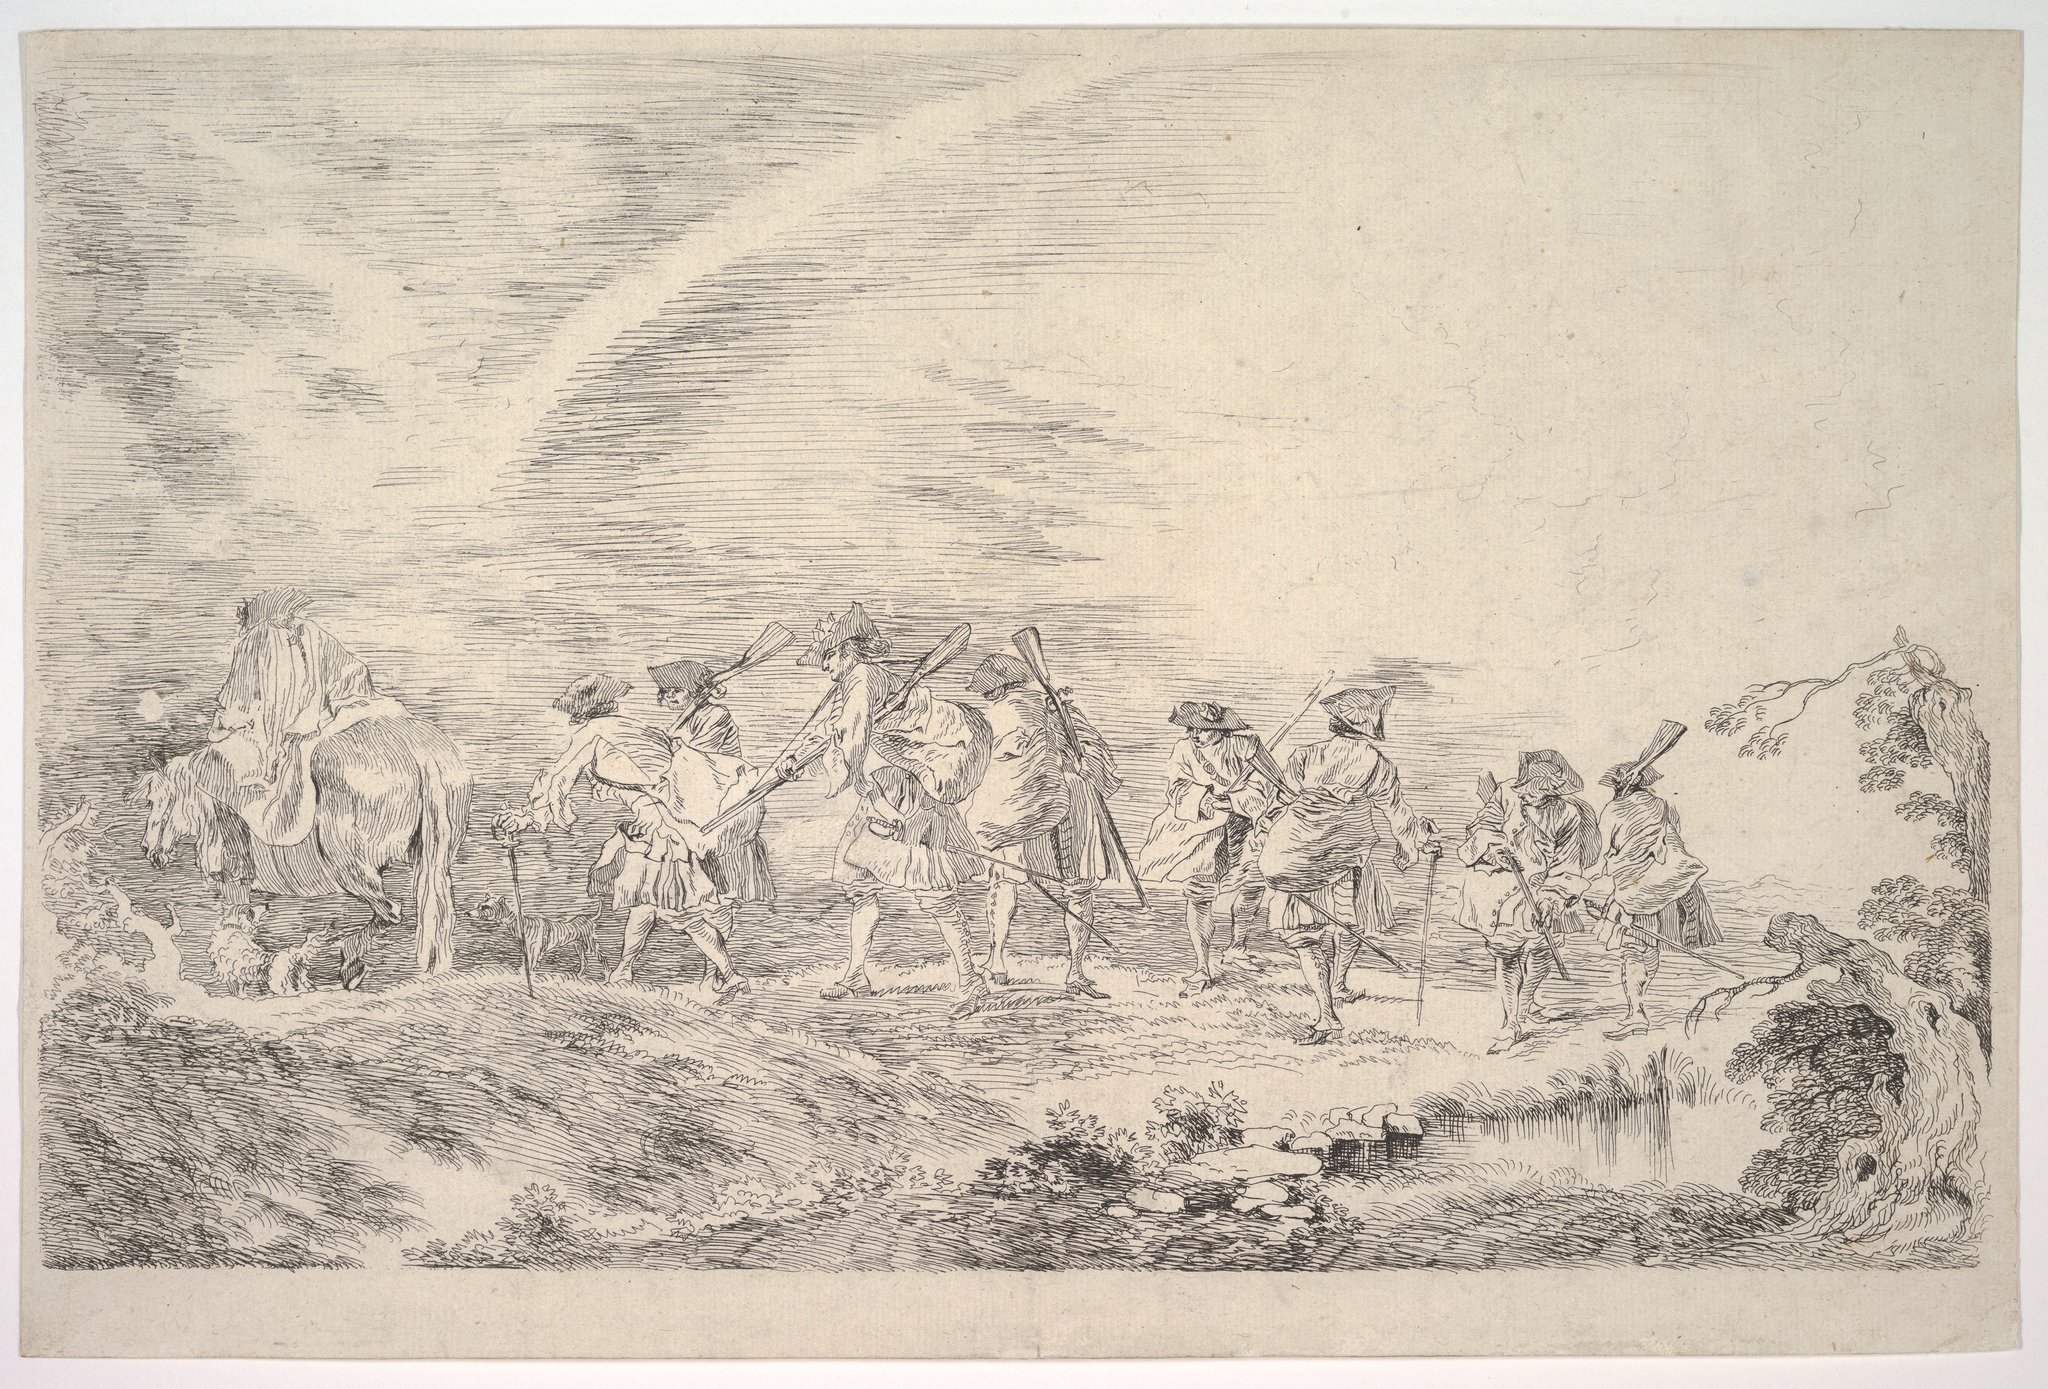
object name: print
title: Recruits Going to Join the Regiment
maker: antoine watteau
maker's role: artist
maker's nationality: french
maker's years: 1684-1721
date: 1715-1716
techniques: drypoint, etching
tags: soldiers,men,horses